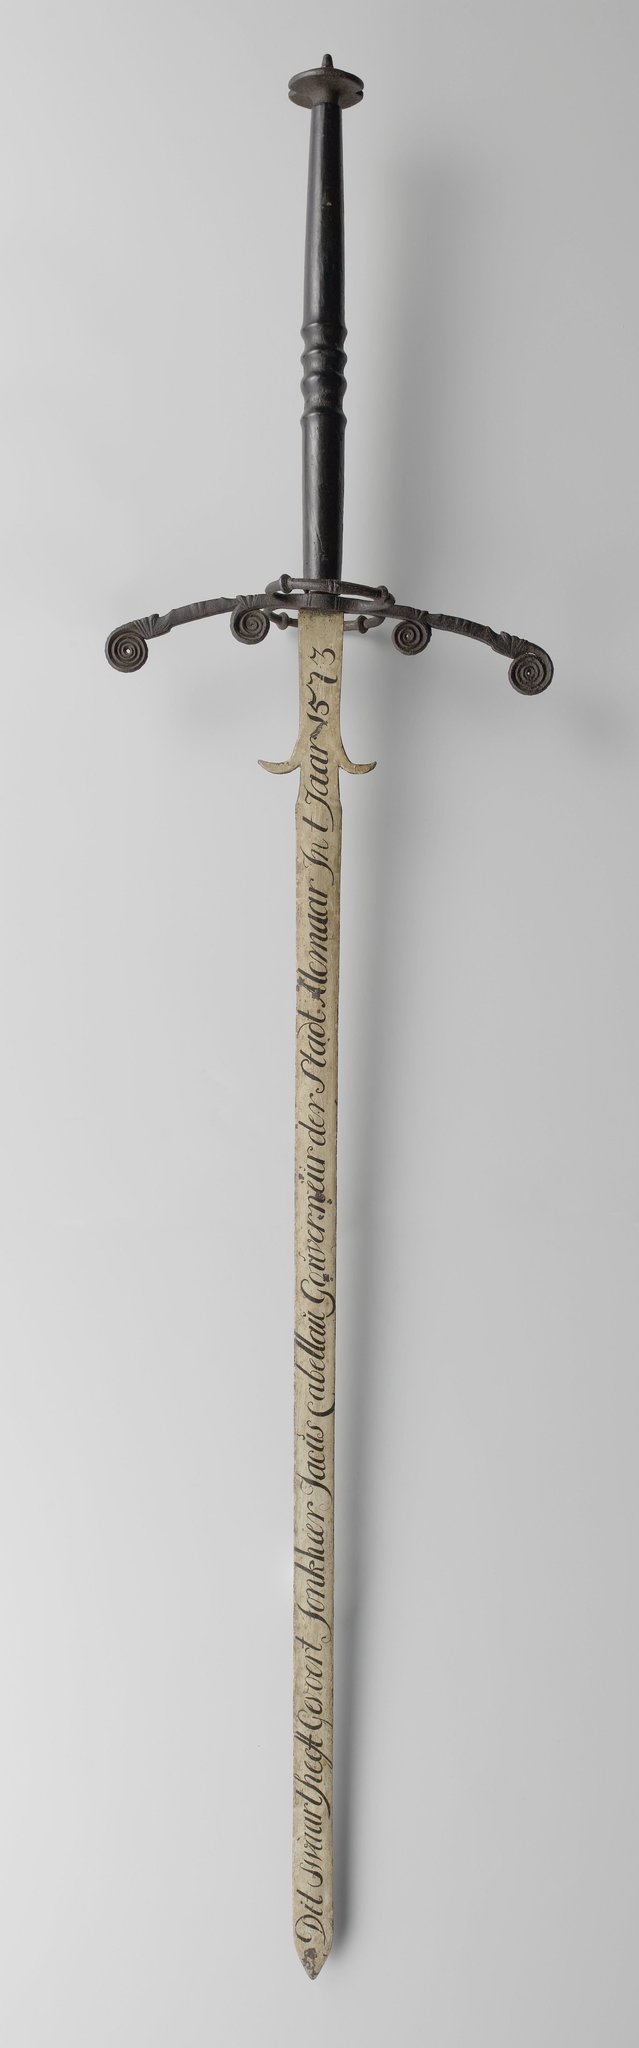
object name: two handed sword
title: Sword of Jacob Cabeljauw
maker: Anonymous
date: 1573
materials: iron, leather, paint, wood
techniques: casting, relief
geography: netherlands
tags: mayor, jacob cabeliau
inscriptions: inscription: ‘Dit swaart heeft Gevoert Jonkheer Jacus cabellau Gouverneur der Stadt Alckmaar In t Jaar 1573’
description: In 1573 the town of Alkmaar was besieged by Spanish troops. The Dutch commander Cabeljauw led the forces that defeated this attack and forced the Spanish to retreat. He was promoted to military governor of Alkmaar and was probably presented with this sword as a token of honour. The text on the blade was presumably added in the 18th century to record the sword’s historical significance.